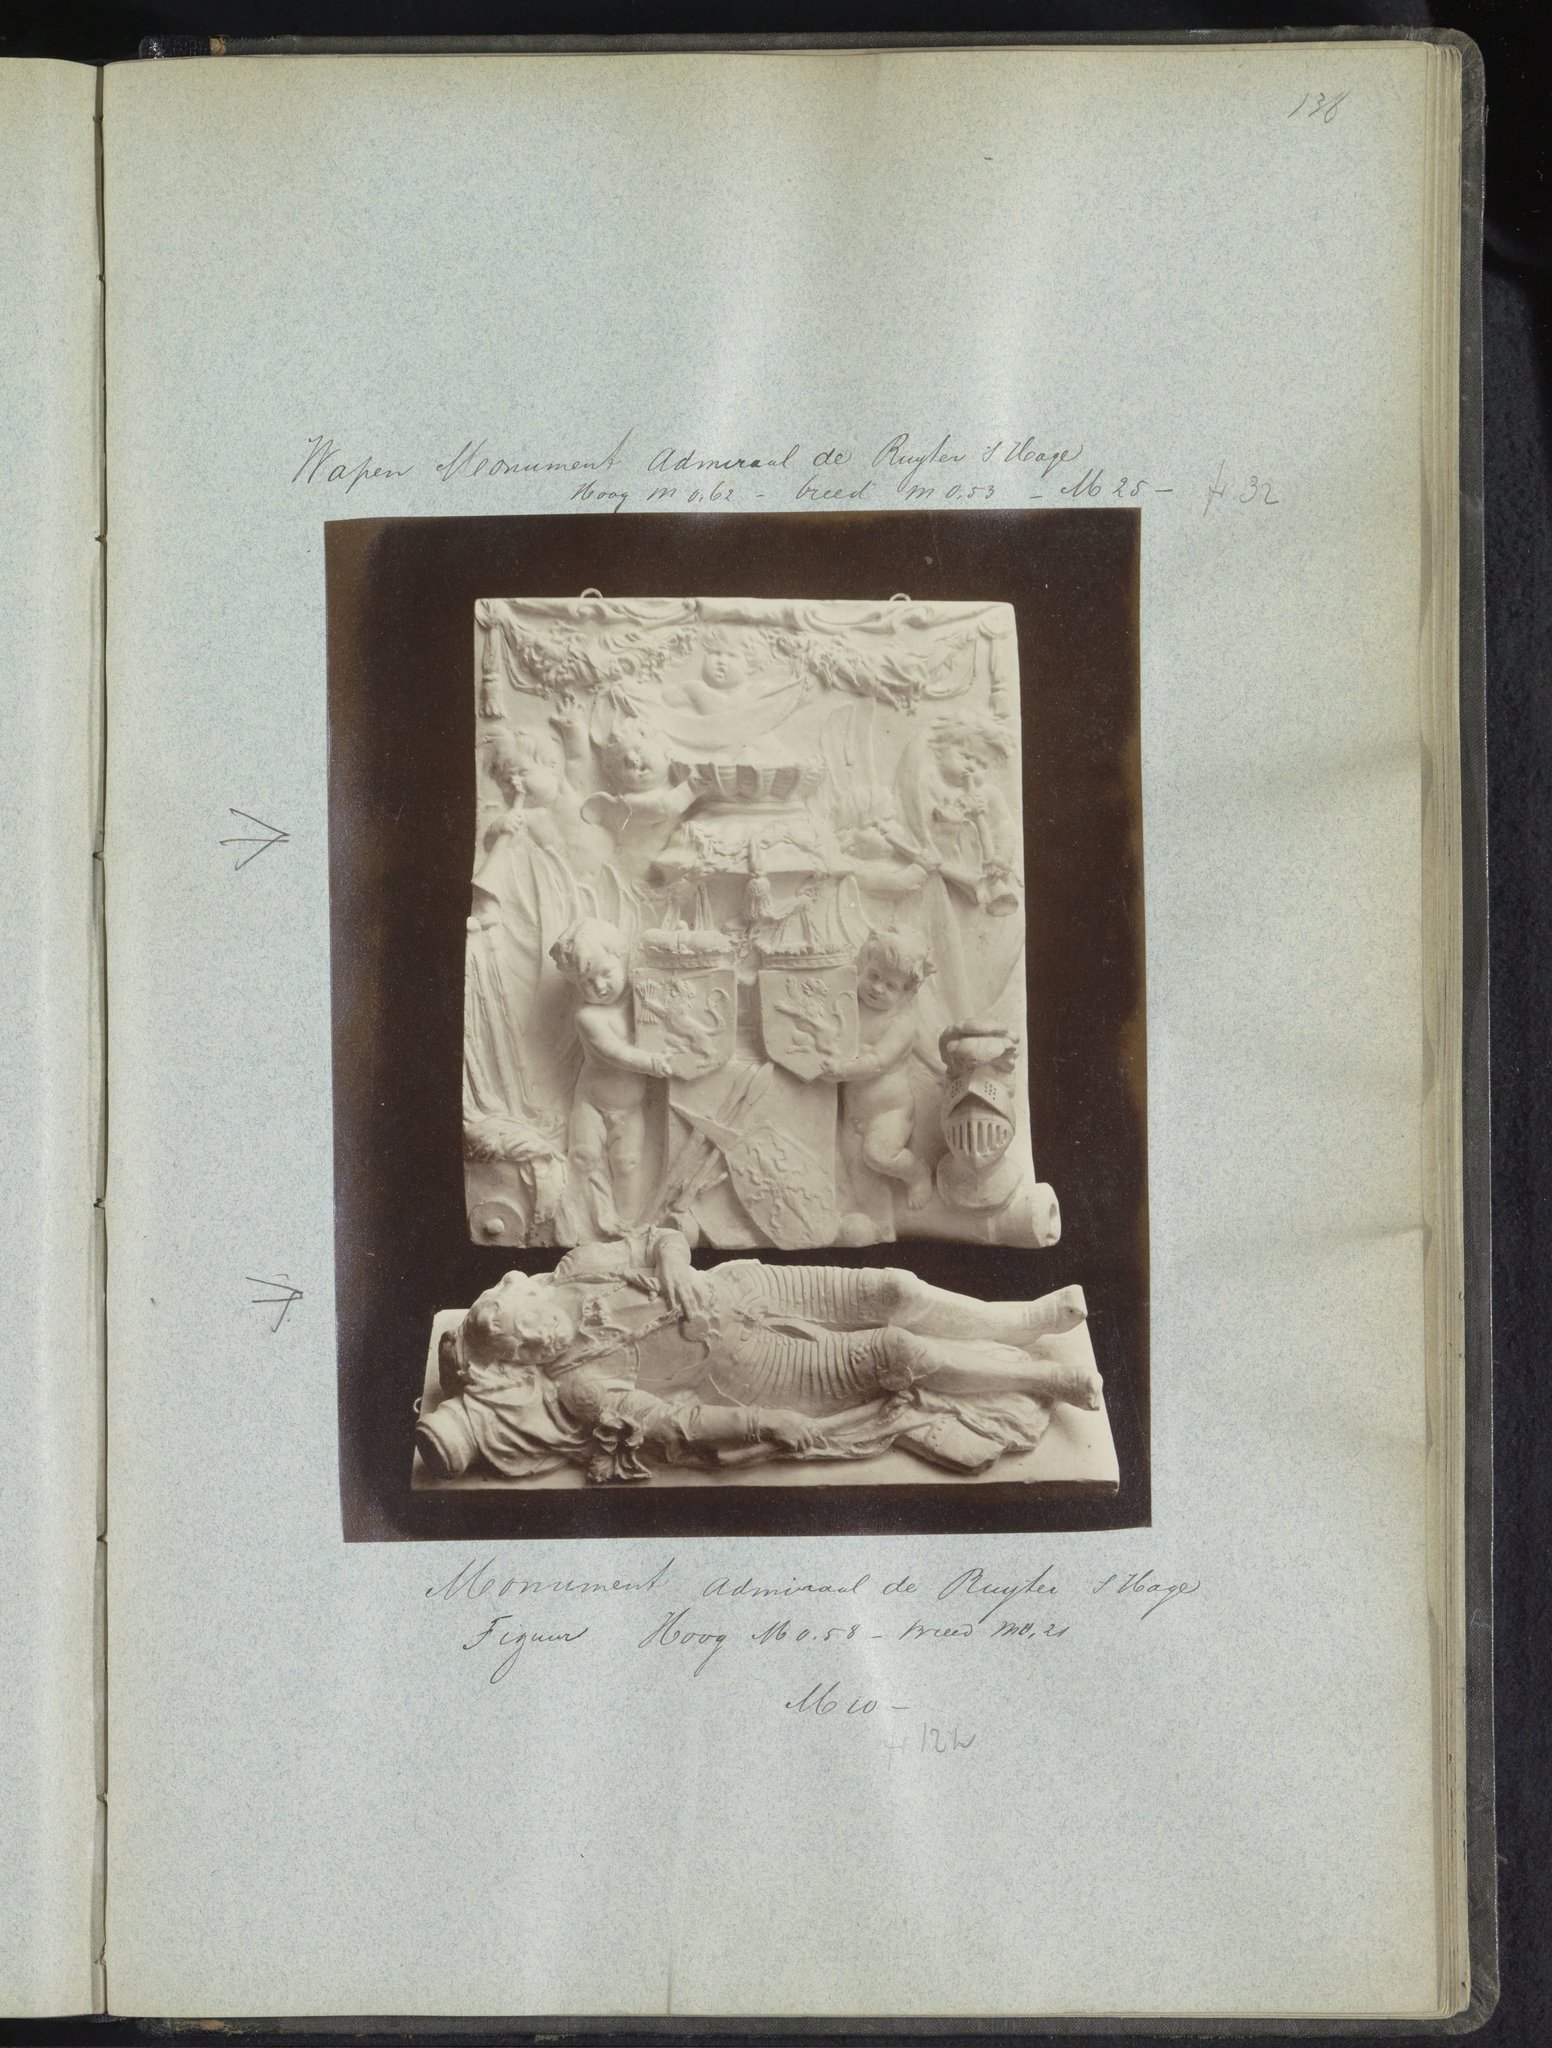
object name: photograph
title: Gipsen afgietsels van een monument van Admiraal de Ruyter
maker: Anonymous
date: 1875-1900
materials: paper, photographic support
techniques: albumen print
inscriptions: annotation, annotation, annotation: ‘Monument Admiraal de Ruijter [...]’